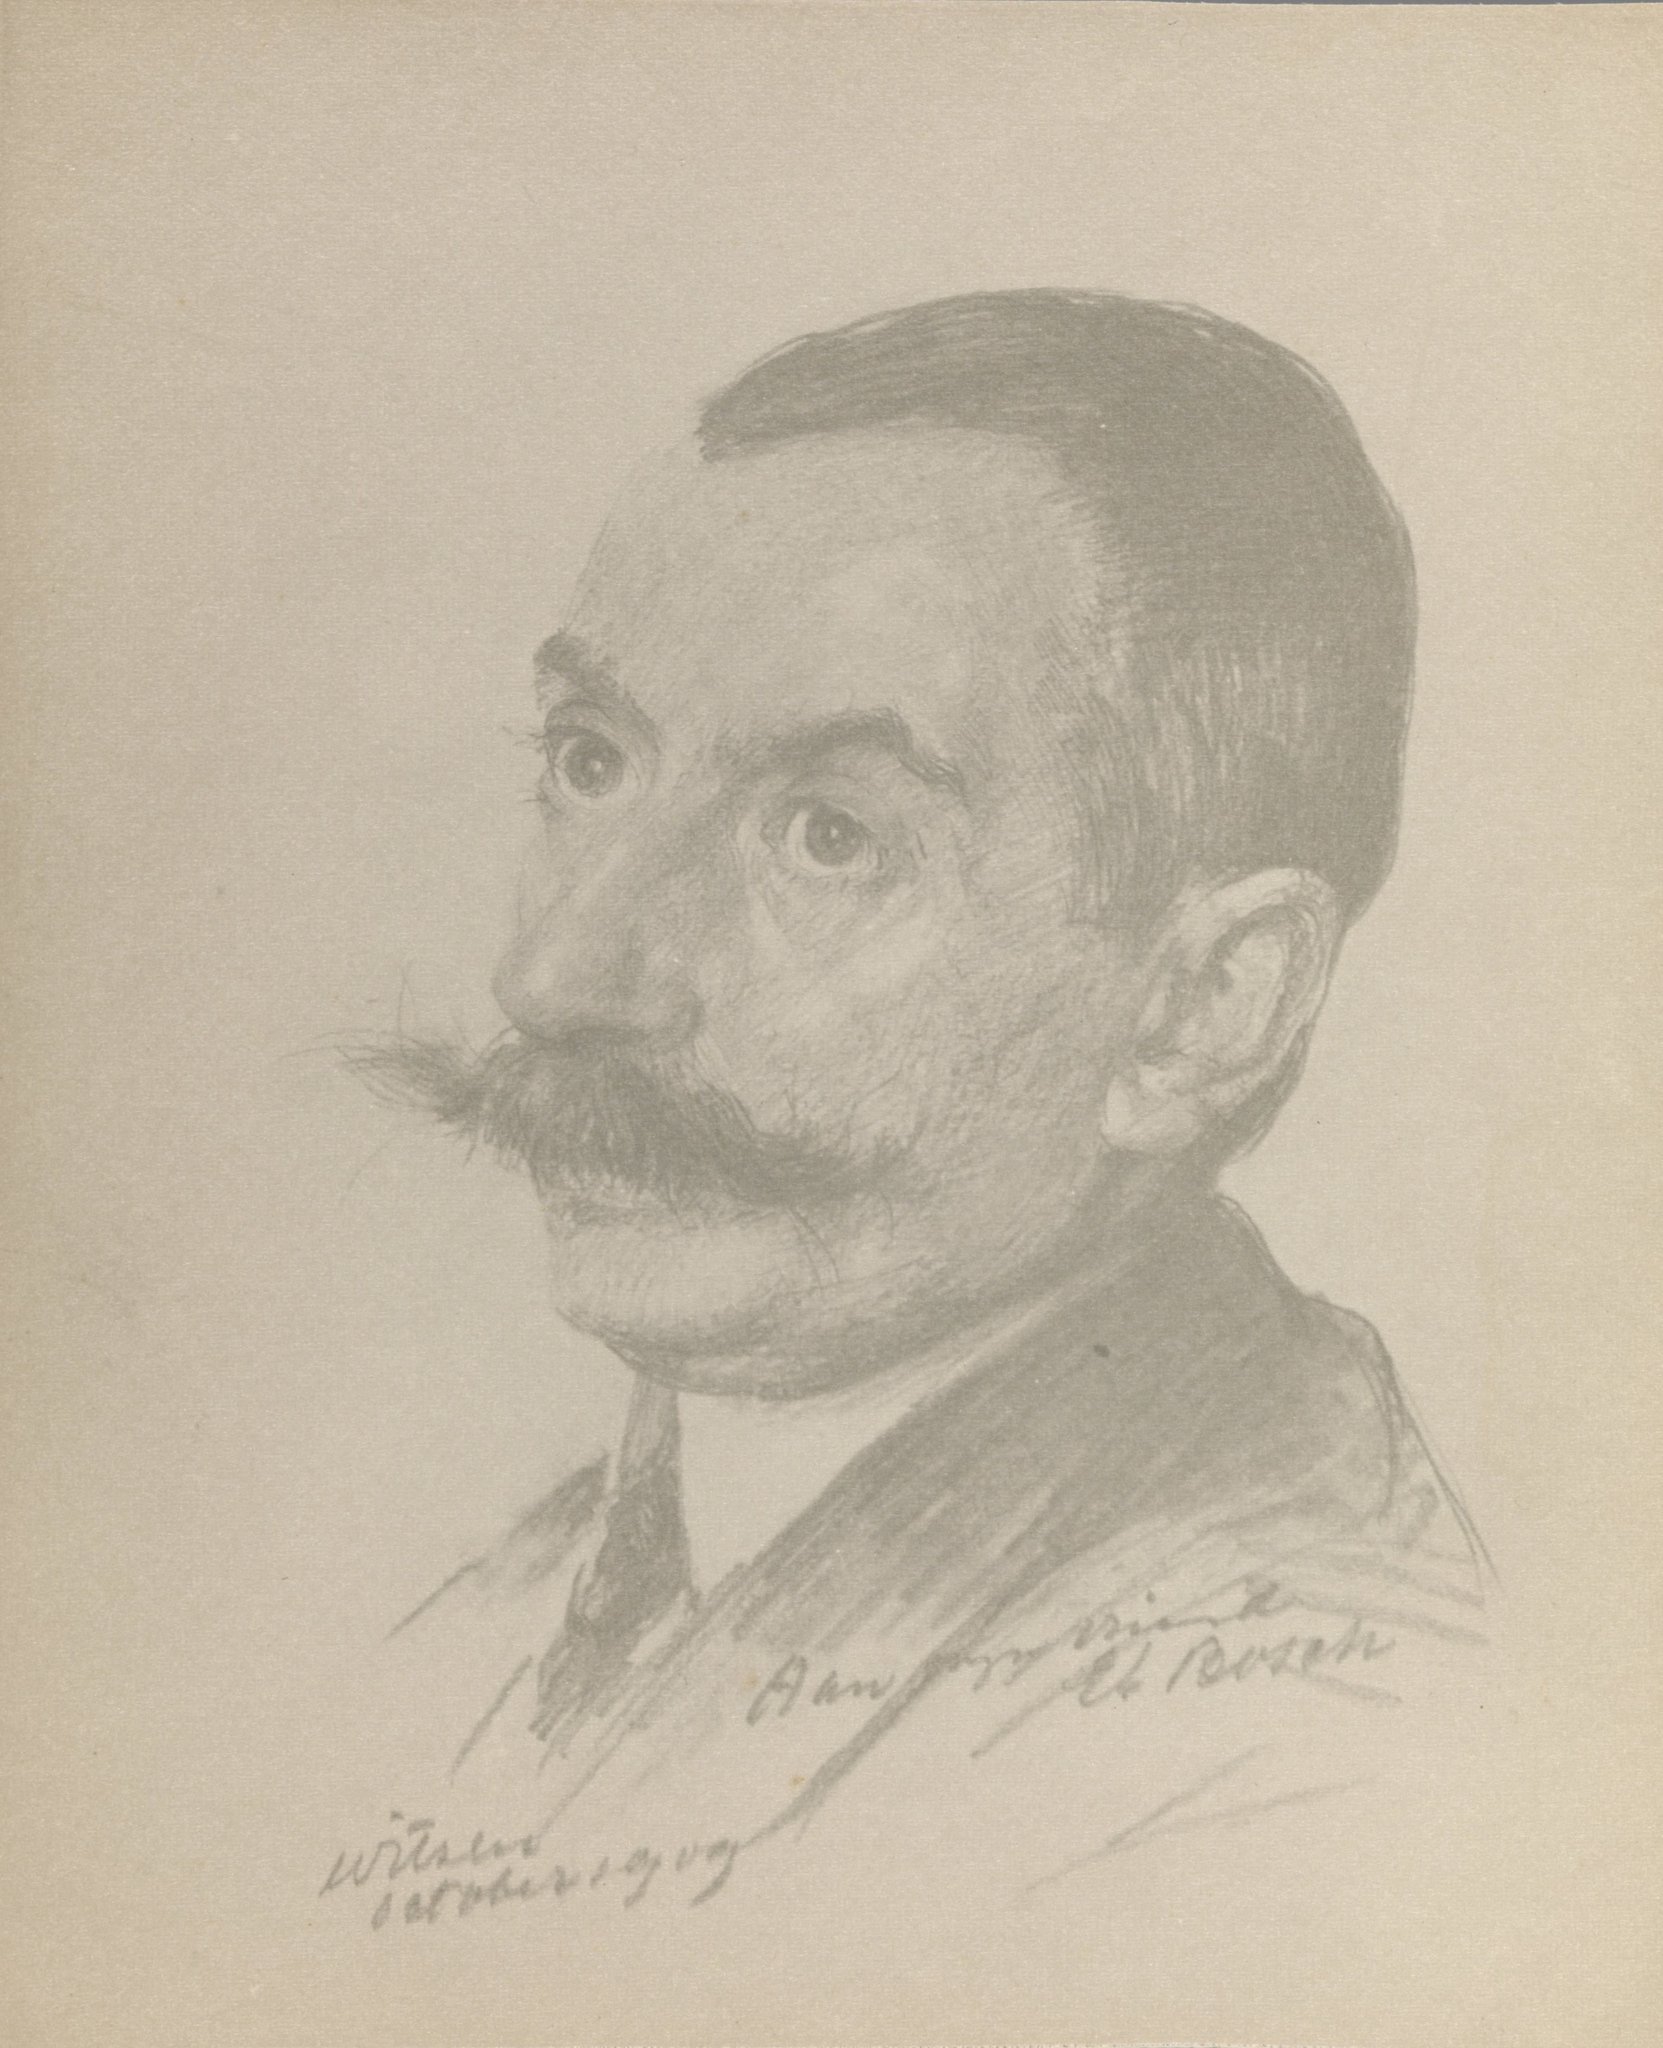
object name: photograph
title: Reproductie naar een foto, schilderij, tekening of prent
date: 1860-1915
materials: paper, photographic support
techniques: gelatin silver print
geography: netherlands